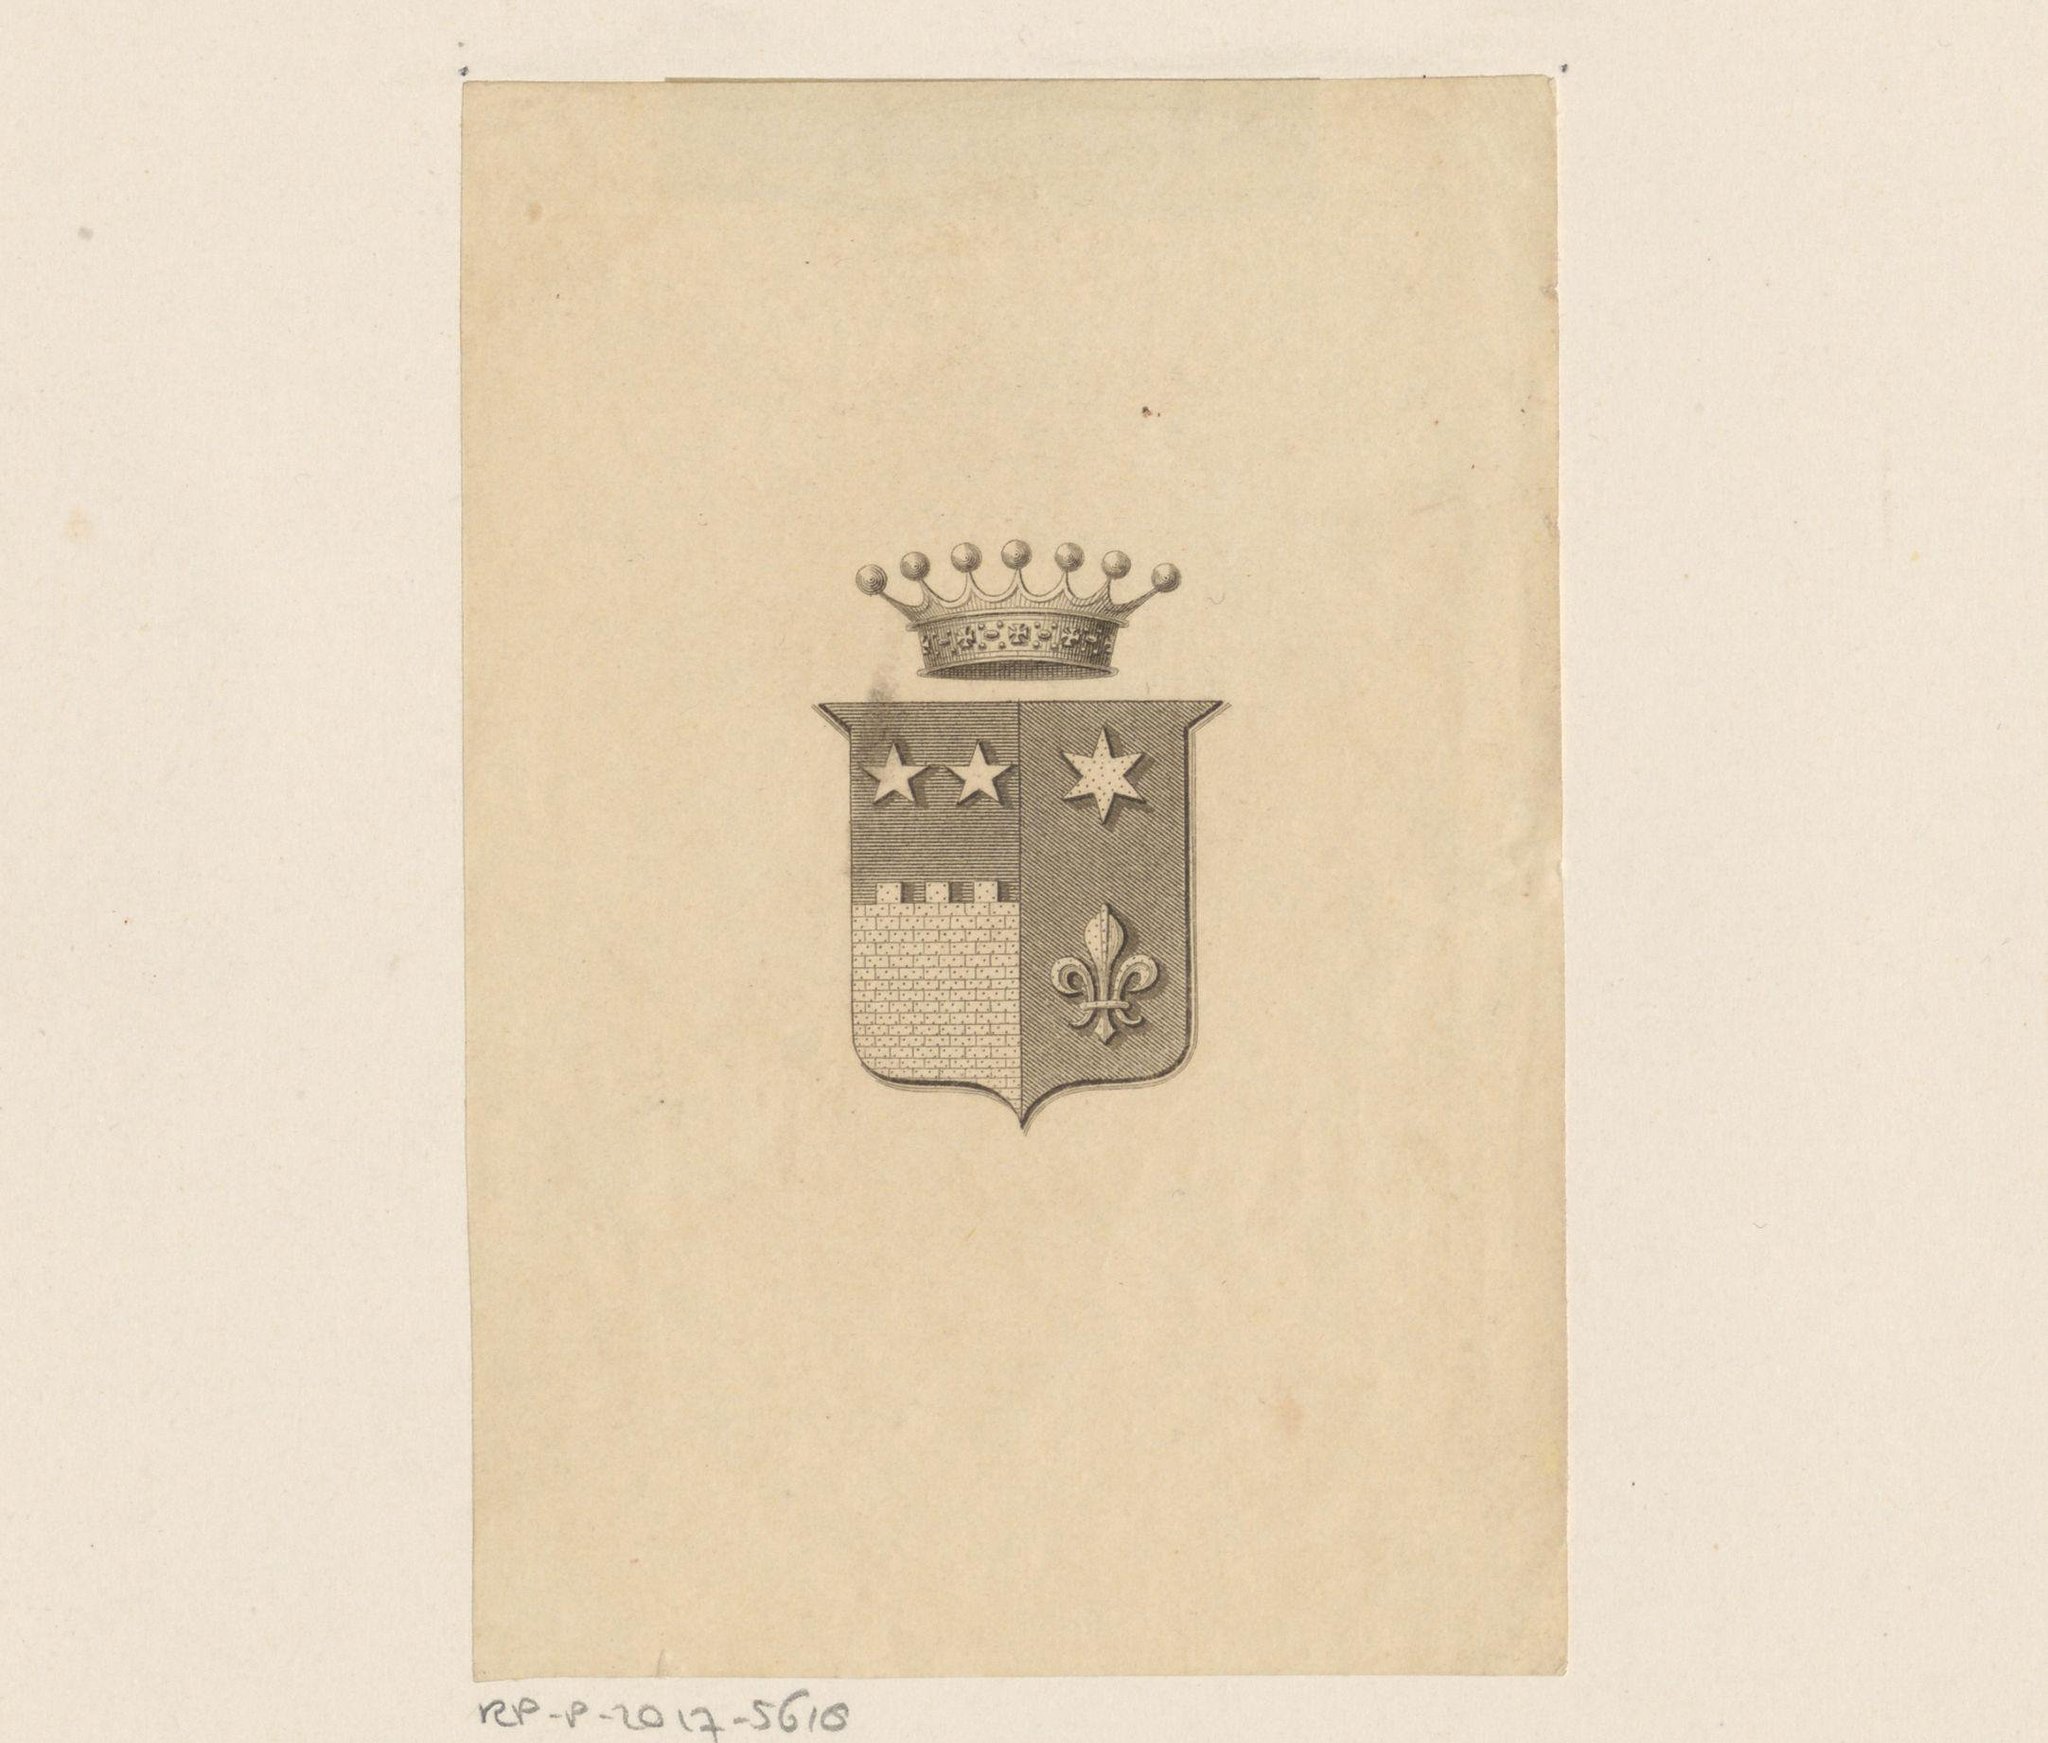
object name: bookplate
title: Ex libris van onbekend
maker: Anonymous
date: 1800-1899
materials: paper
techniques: etching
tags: fleur-de-lis ~ ornament, stars, armorial bearing, heraldry